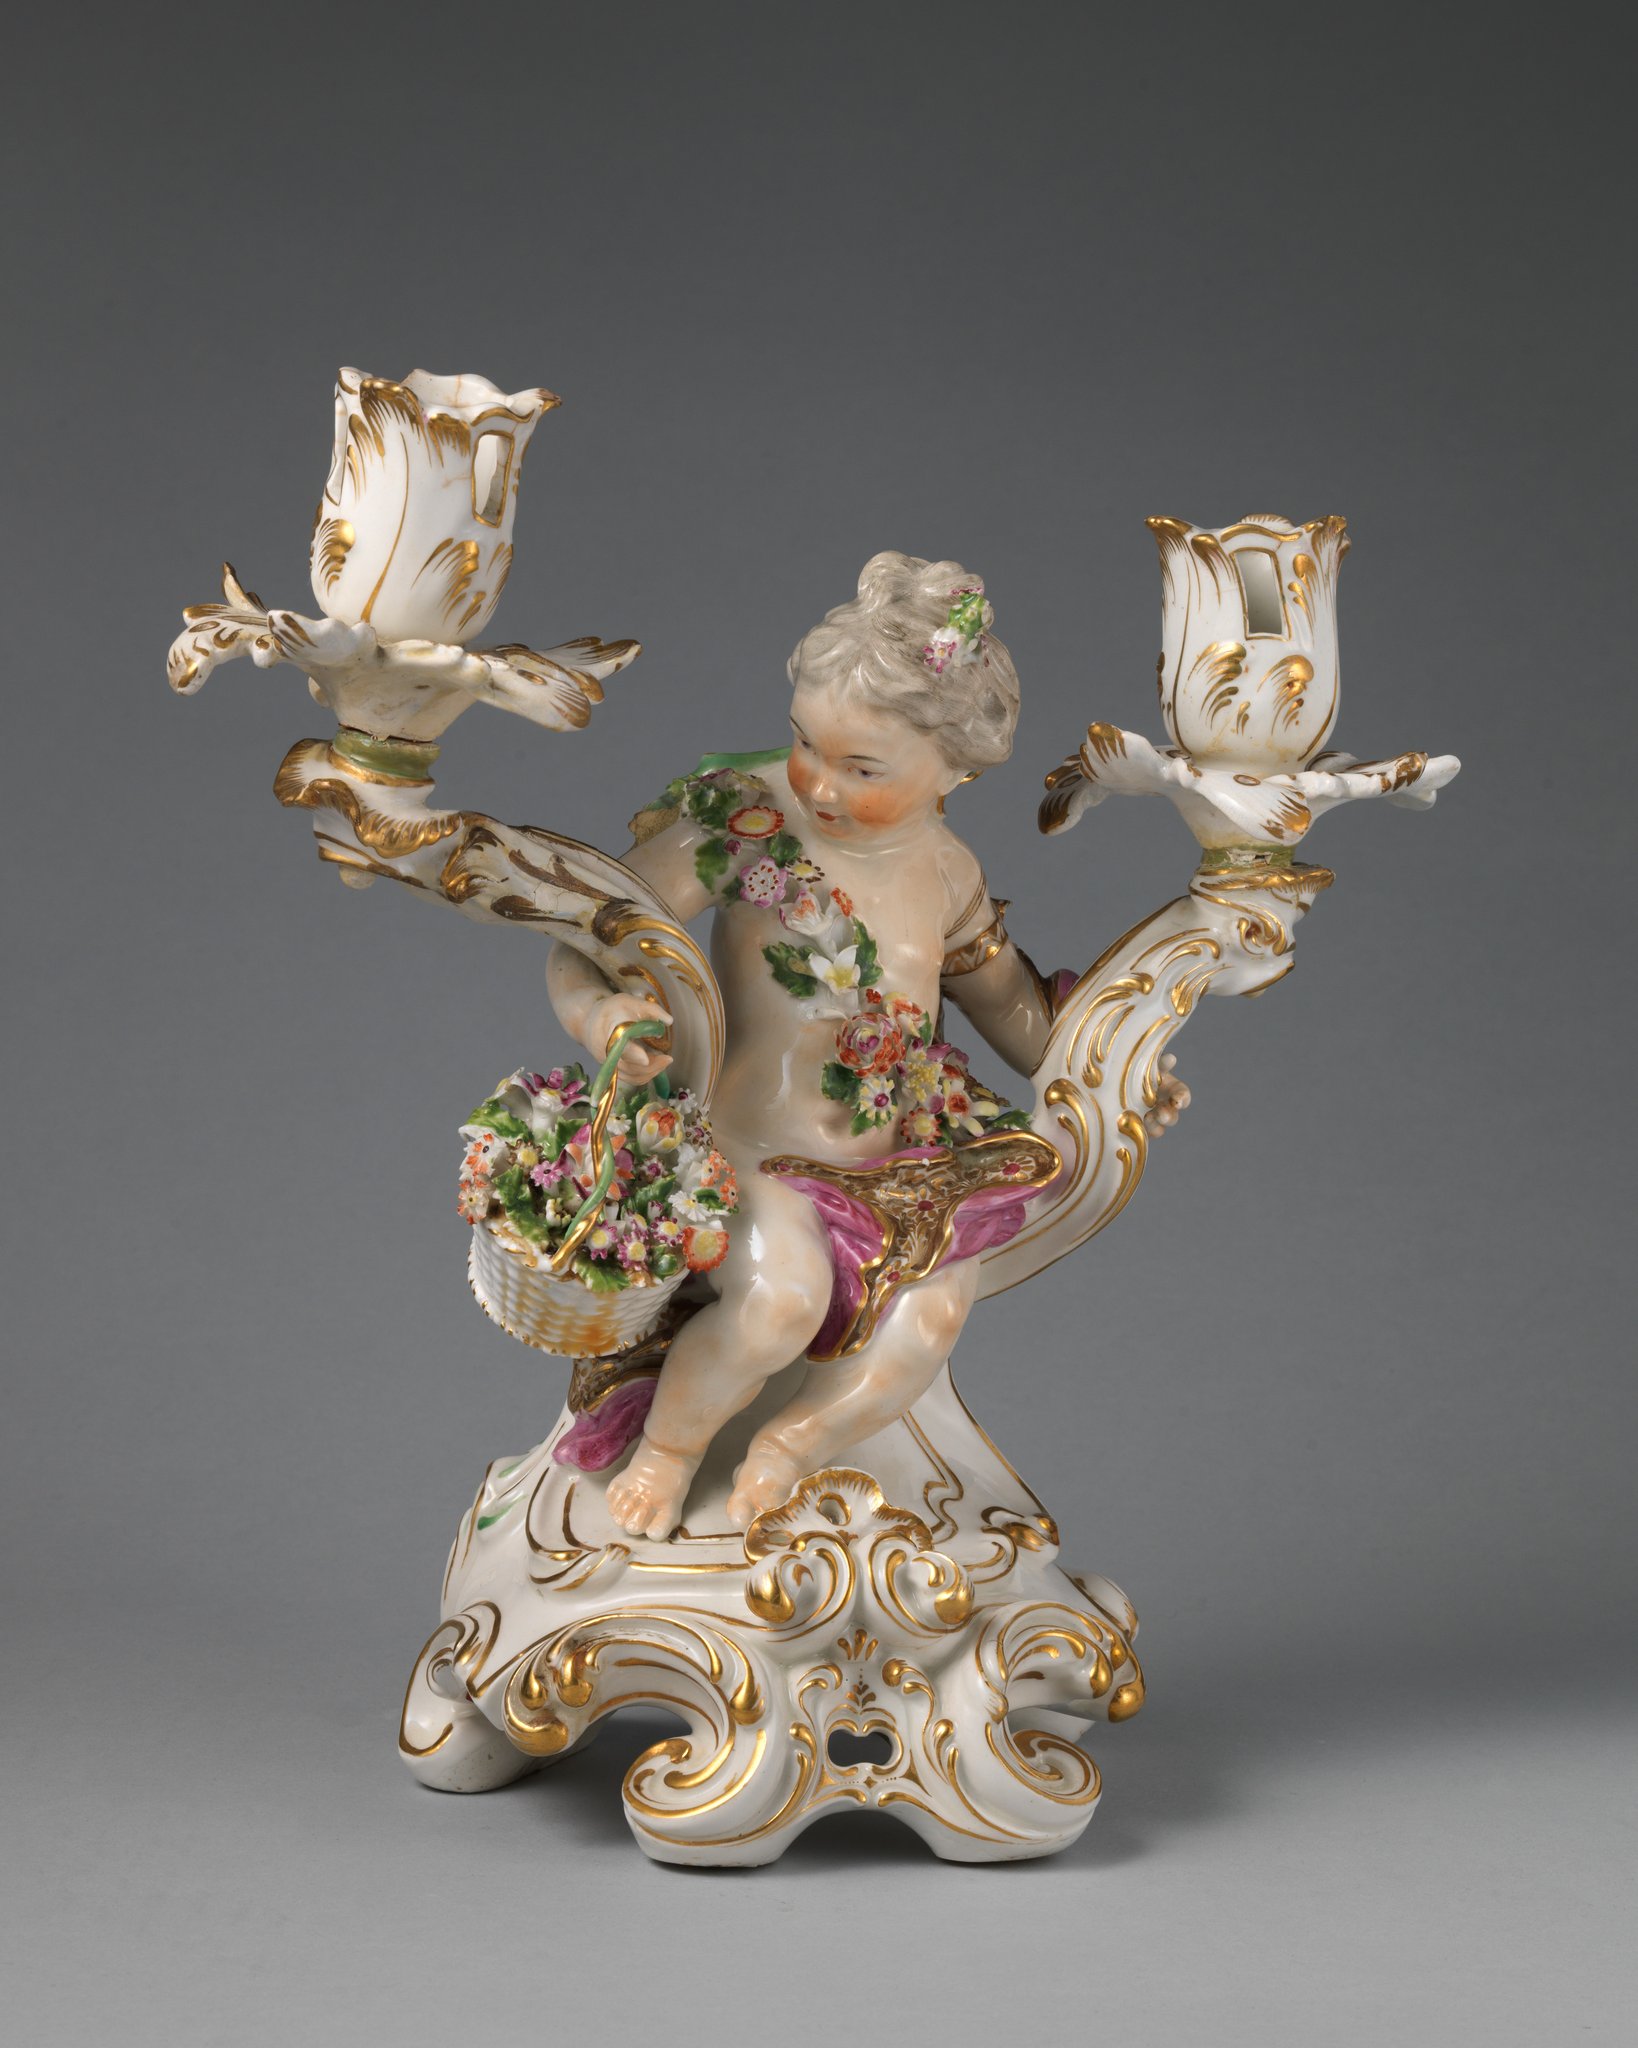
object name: candelabrum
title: Candelabrum (one of a pair)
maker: chelsea porcelain manufactory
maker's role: factory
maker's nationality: british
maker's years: 1744-1784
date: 1701-1800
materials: soft paste porcelain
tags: children